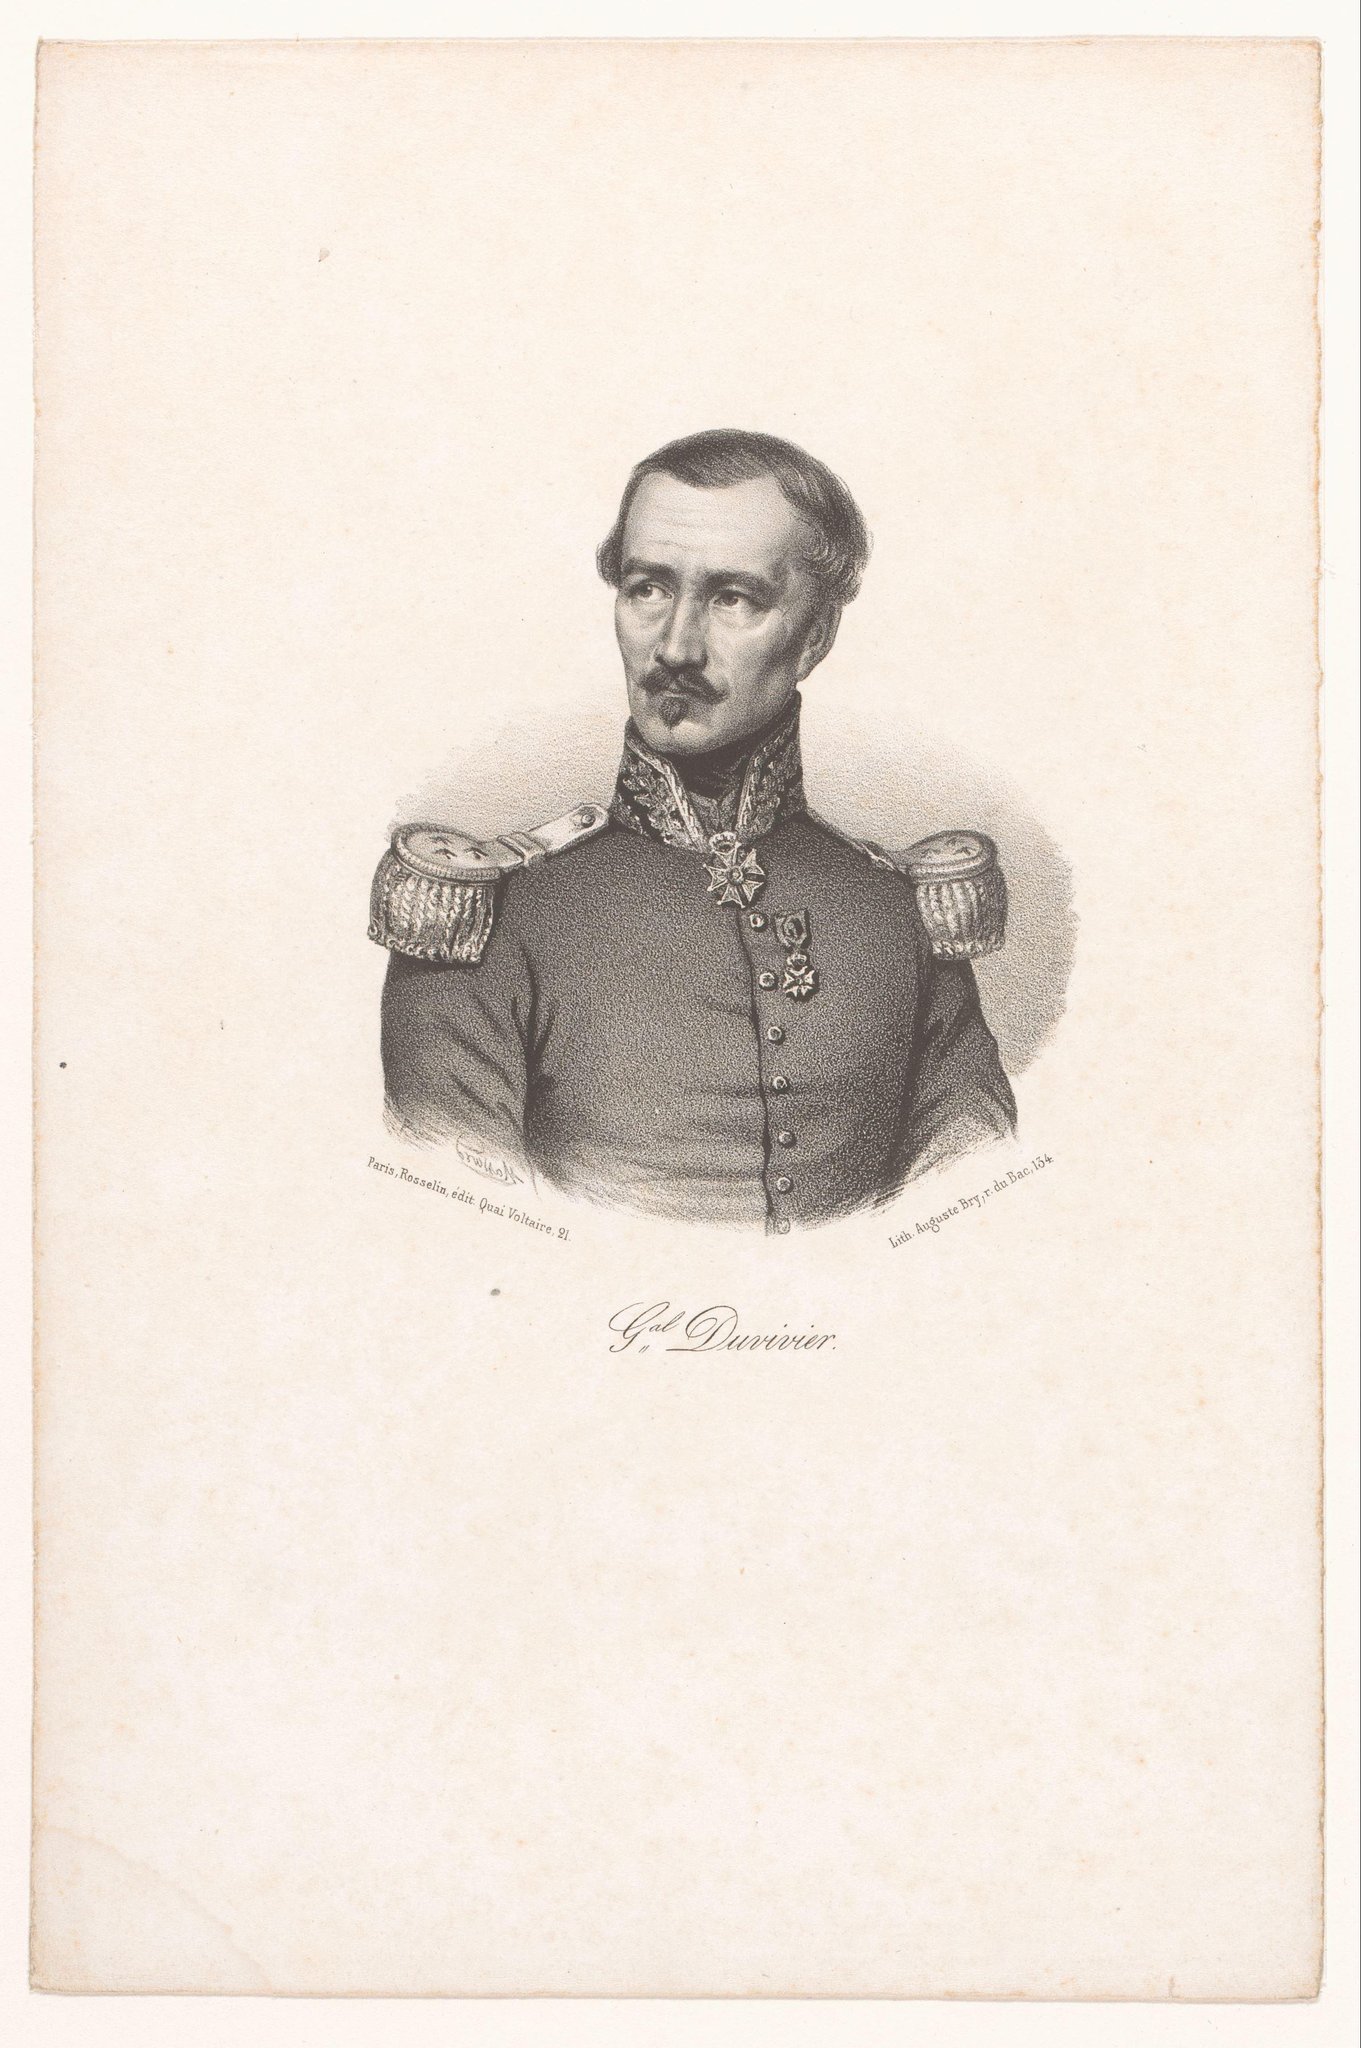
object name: print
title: Portret van generaal Franciade Fleurus Duvivier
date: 1848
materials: paper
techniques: lithograph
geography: paris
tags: historical persons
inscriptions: collector's mark: Lugt 2228